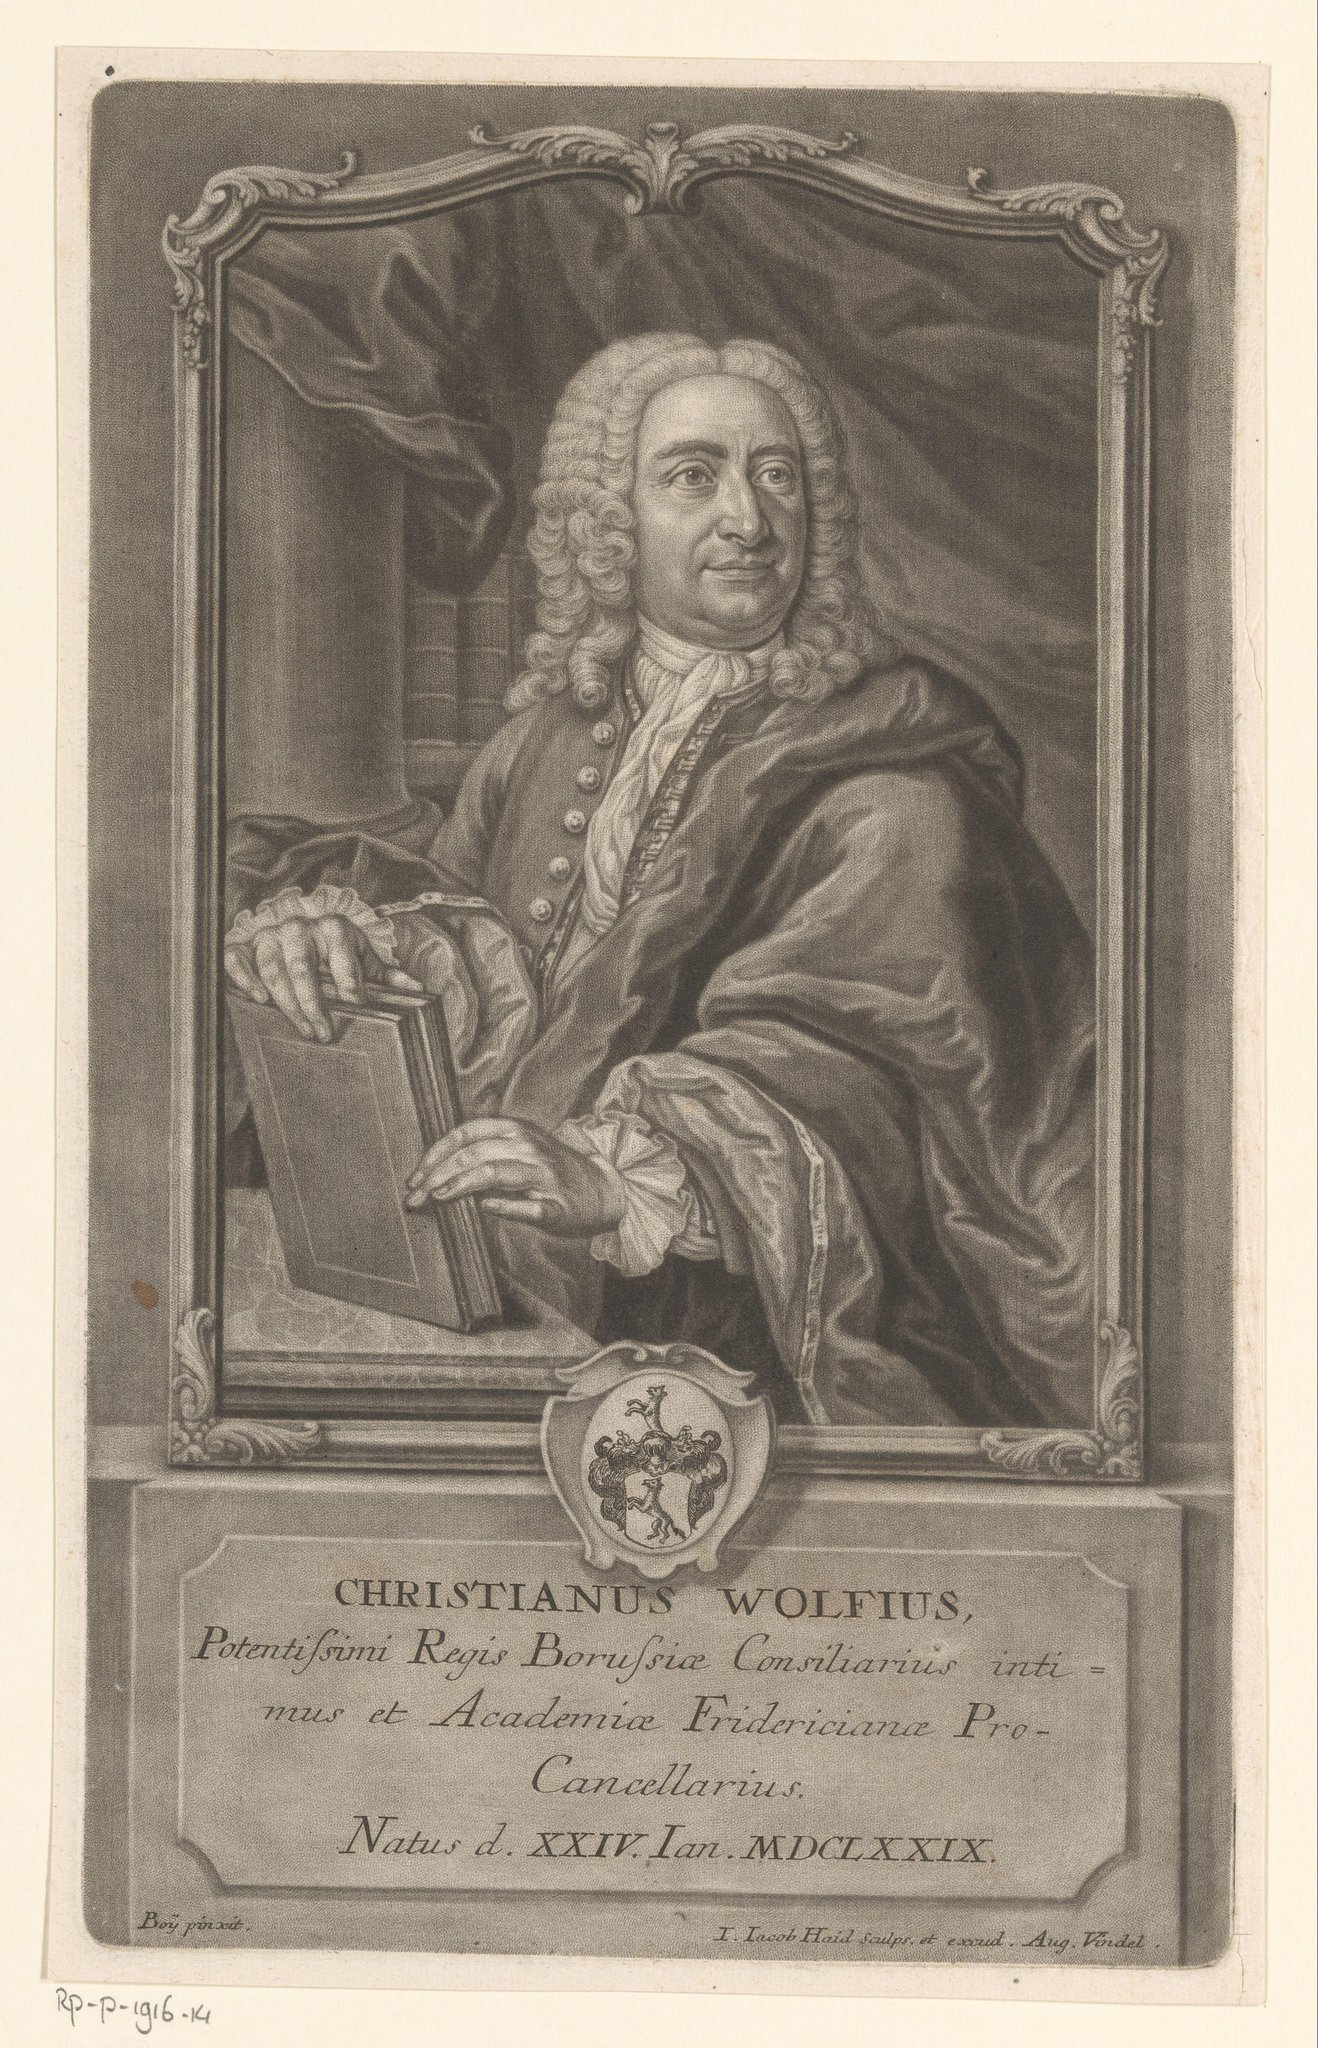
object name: print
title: Portret van Christian Wolff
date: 1714-1754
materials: paper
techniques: etching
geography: augsburg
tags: bookshelves, historical persons, book, armorial bearing, heraldry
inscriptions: collector's mark: Lugt 2228